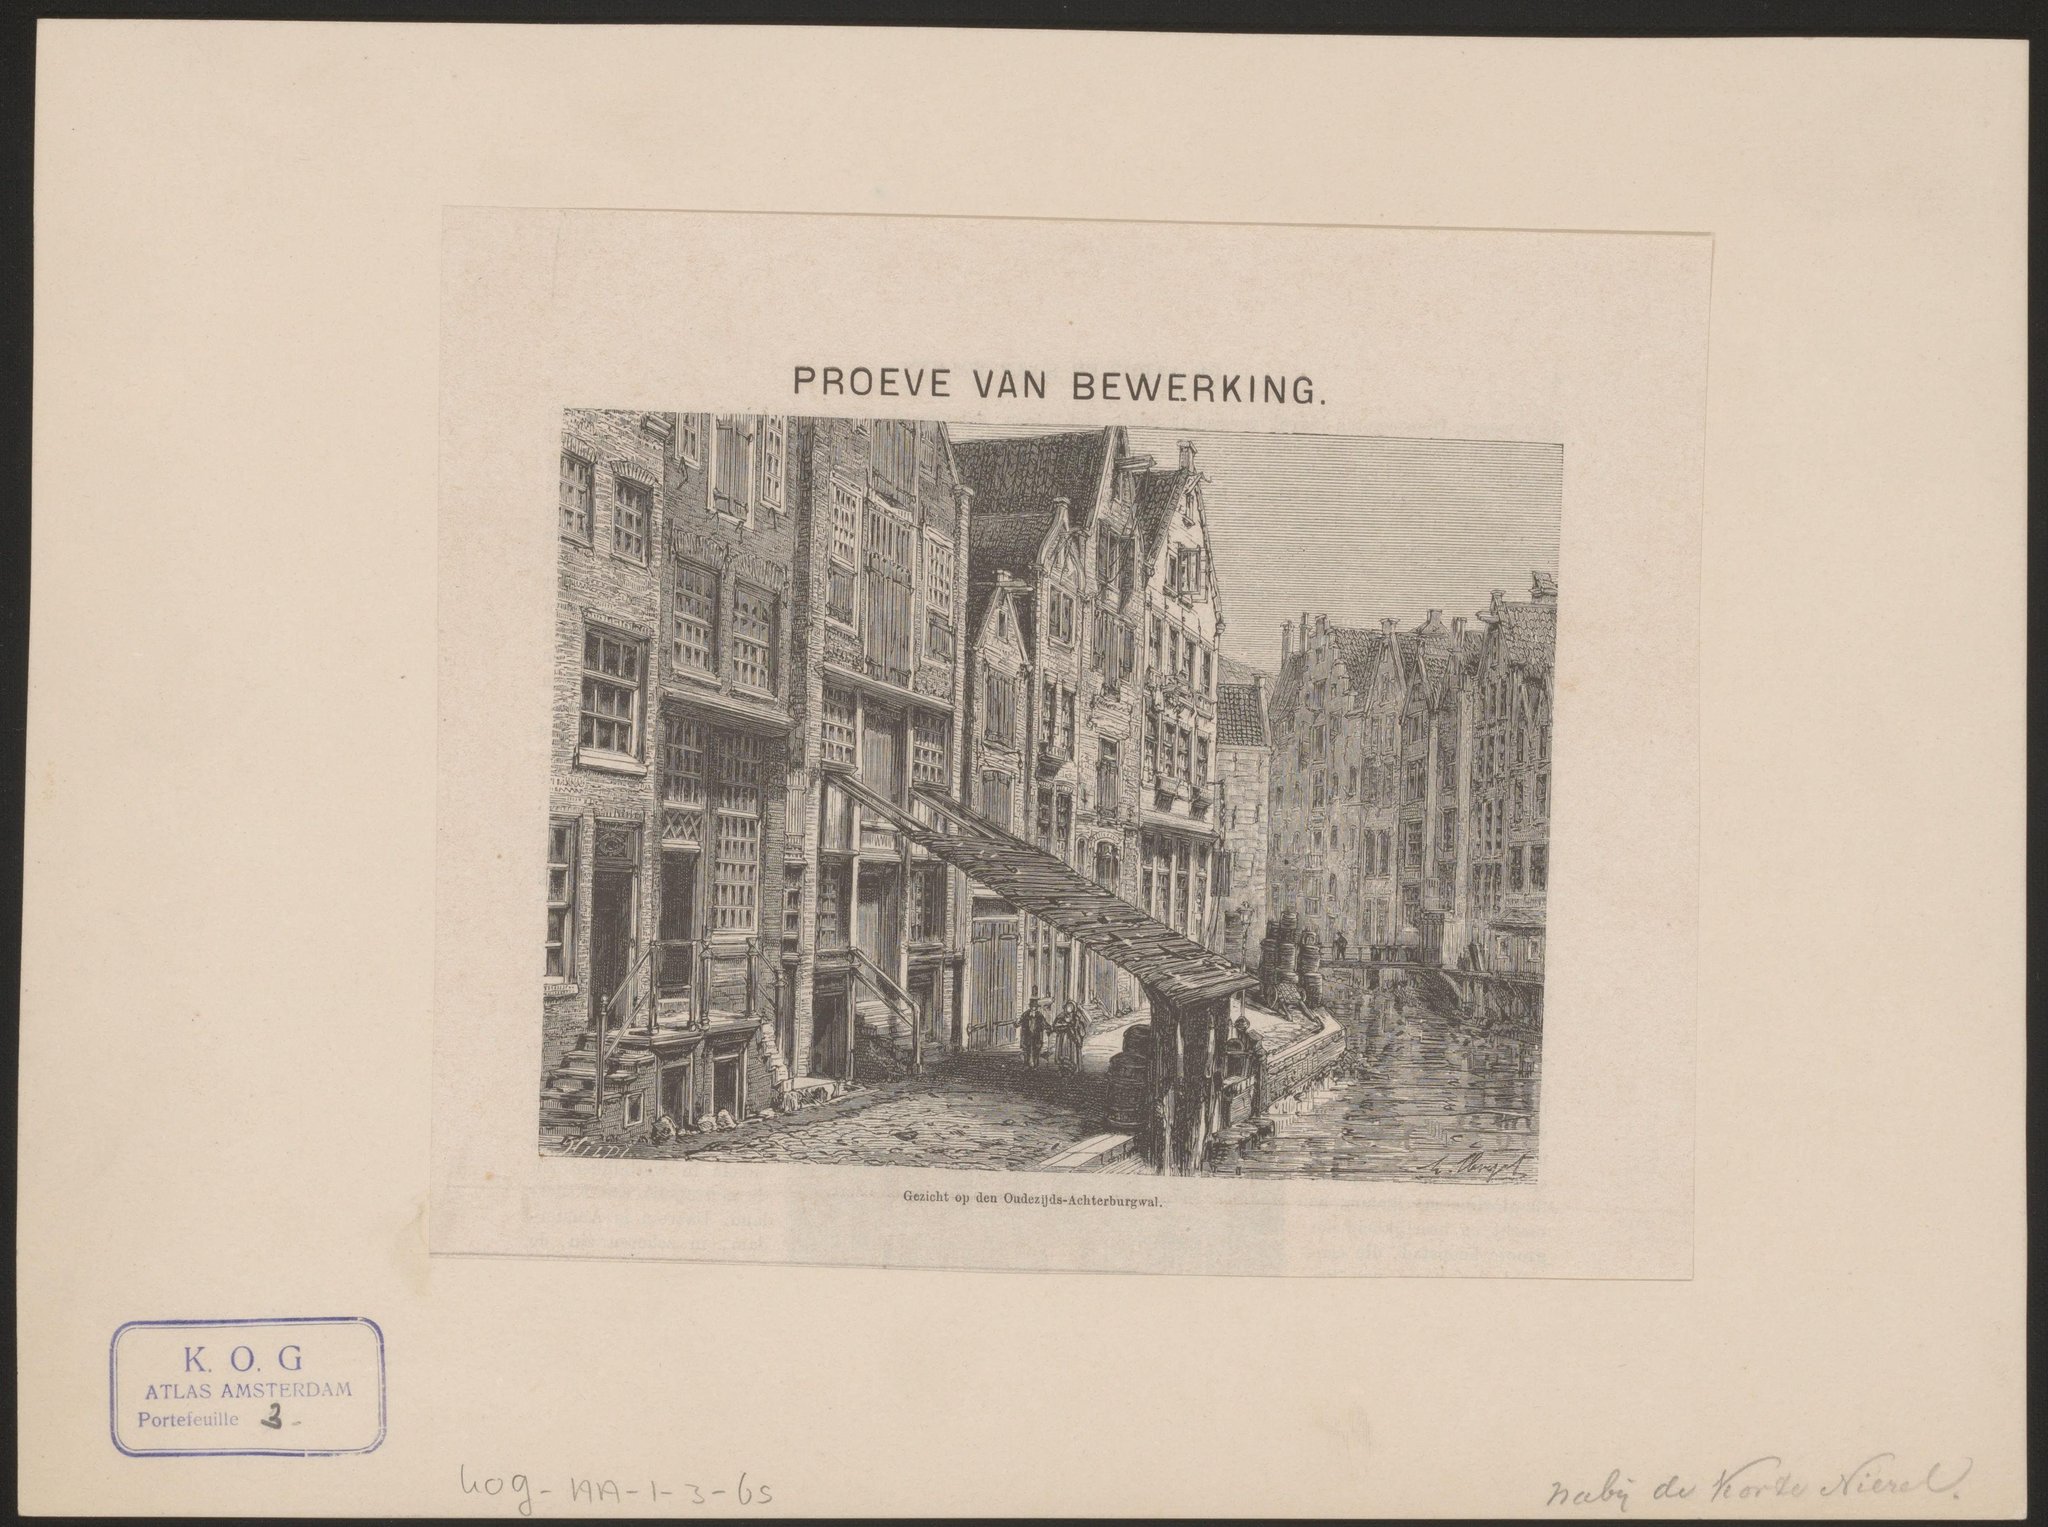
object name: print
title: Gezicht op de Oudezijds Achterburgwal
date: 1878-1899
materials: paper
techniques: letterpress printing, engraving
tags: city-view in general; 'veduta', canal, the usual house or row of houses, bridge in city across river, canal, etc.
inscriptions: collector's mark: ‘3’ Lugt 1641b, inscription: ‘Nabij de Korte Niezel’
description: Onderwerpsrubriek binnen de Atlas Amsterdam: Achterburgwal, Nieuwezijds en - Oudezijds; Nieuwe Achtergracht, Achterweg, Akoleienstraat.